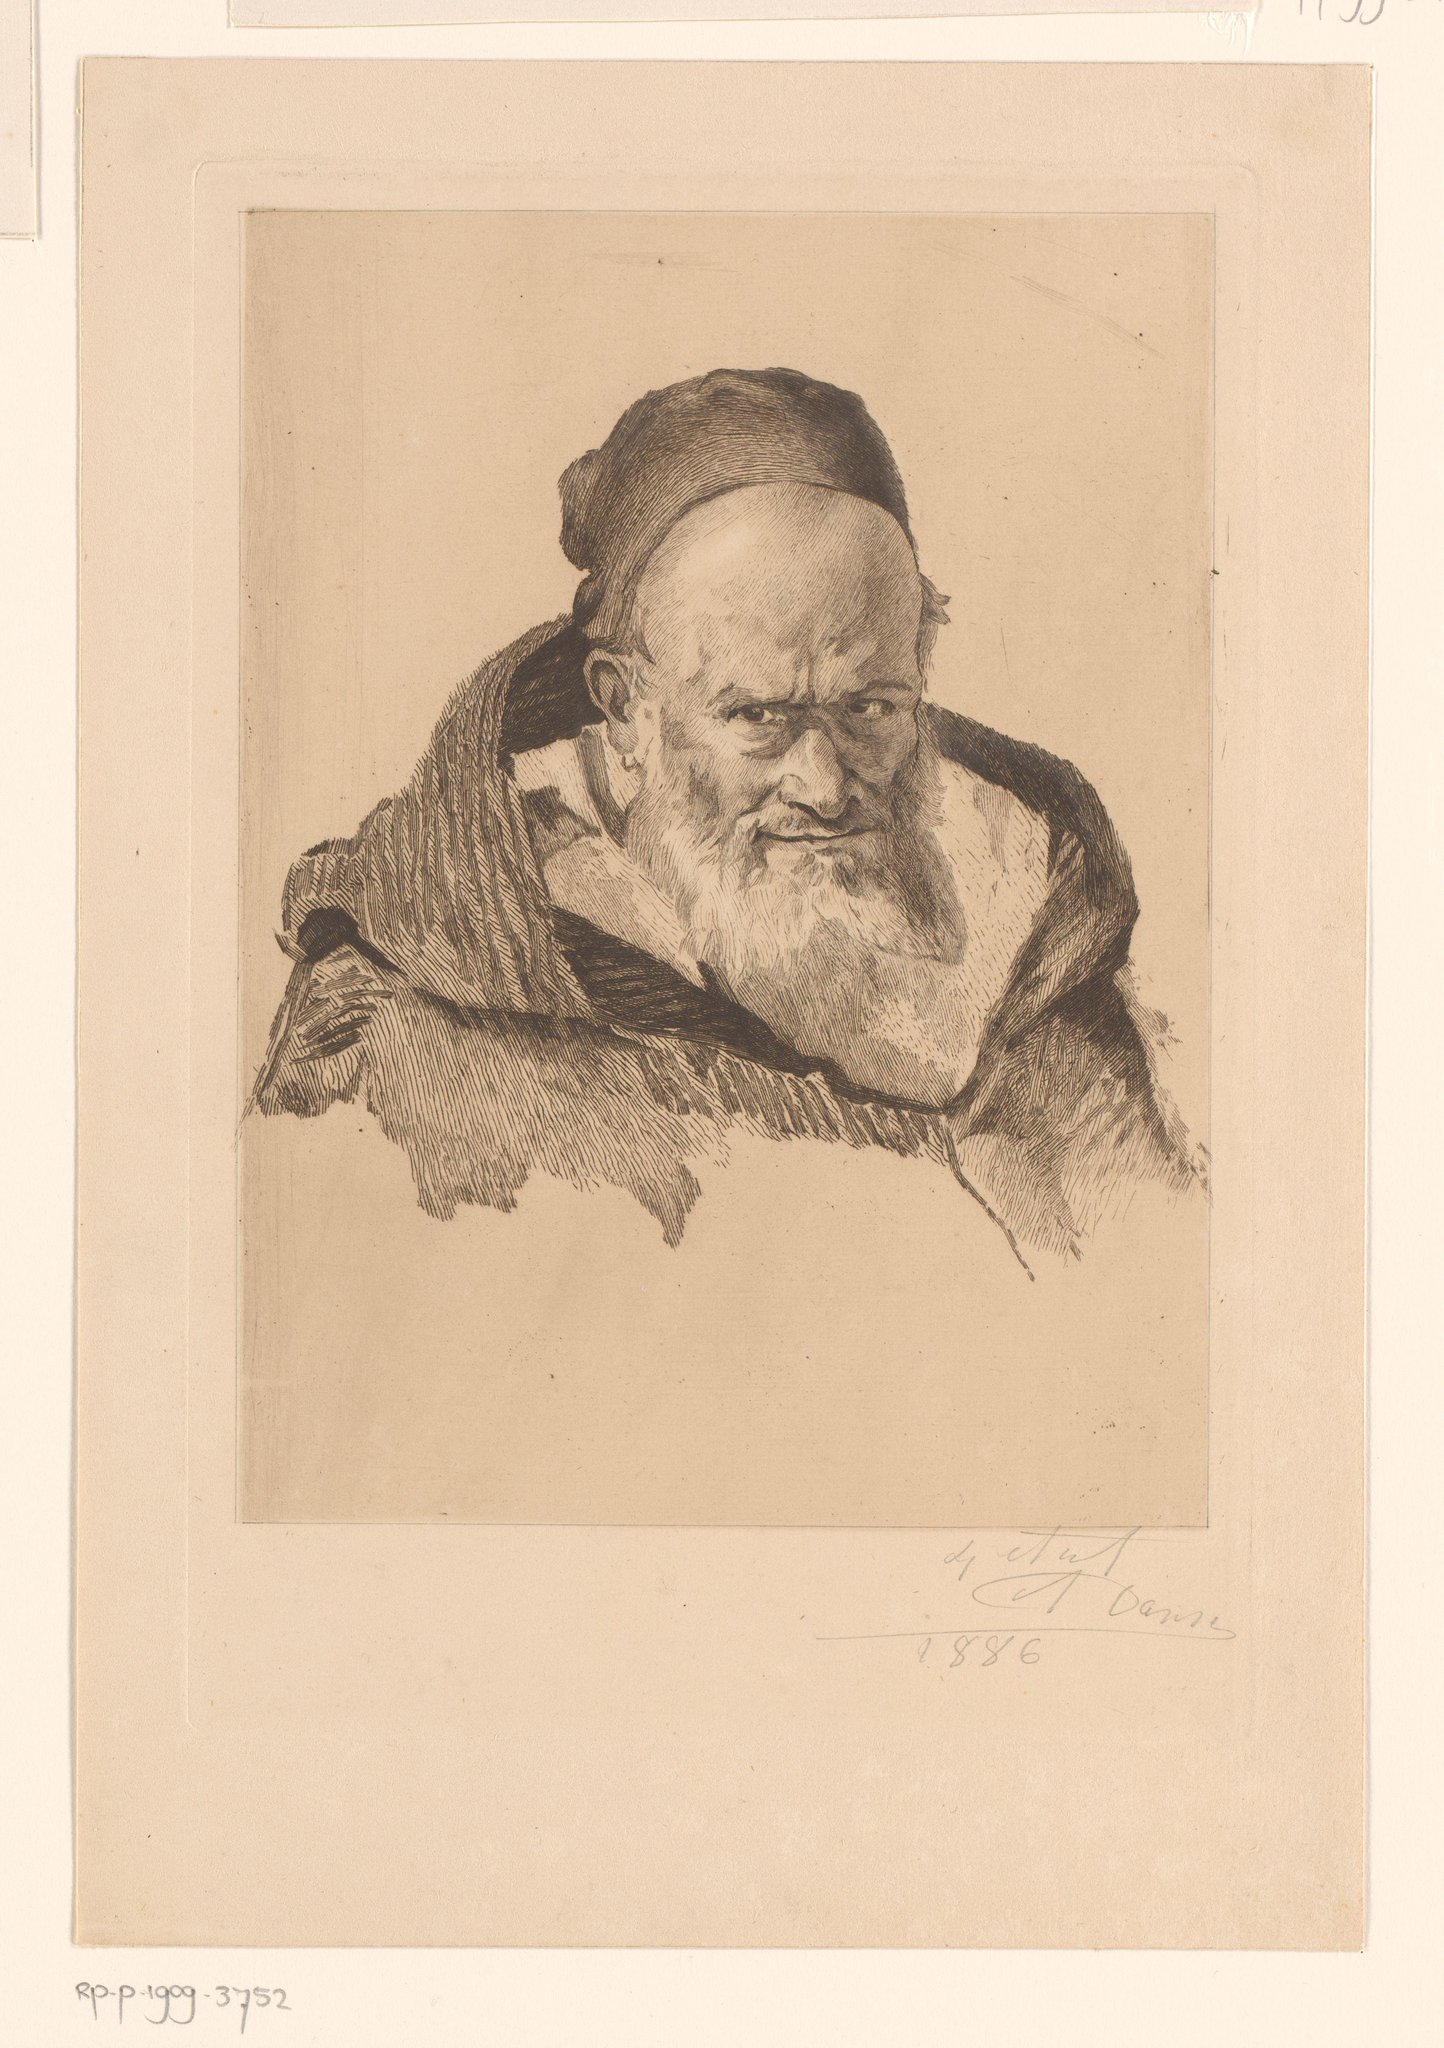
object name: print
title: Hoofd van een bebaarde man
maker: auguste danse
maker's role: print maker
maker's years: 1829-1929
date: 1886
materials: paper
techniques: etching, intaglio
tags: anonymous historical person portrayed alone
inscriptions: collector's mark: Lugt 2228, annotation: ‘4 etat’